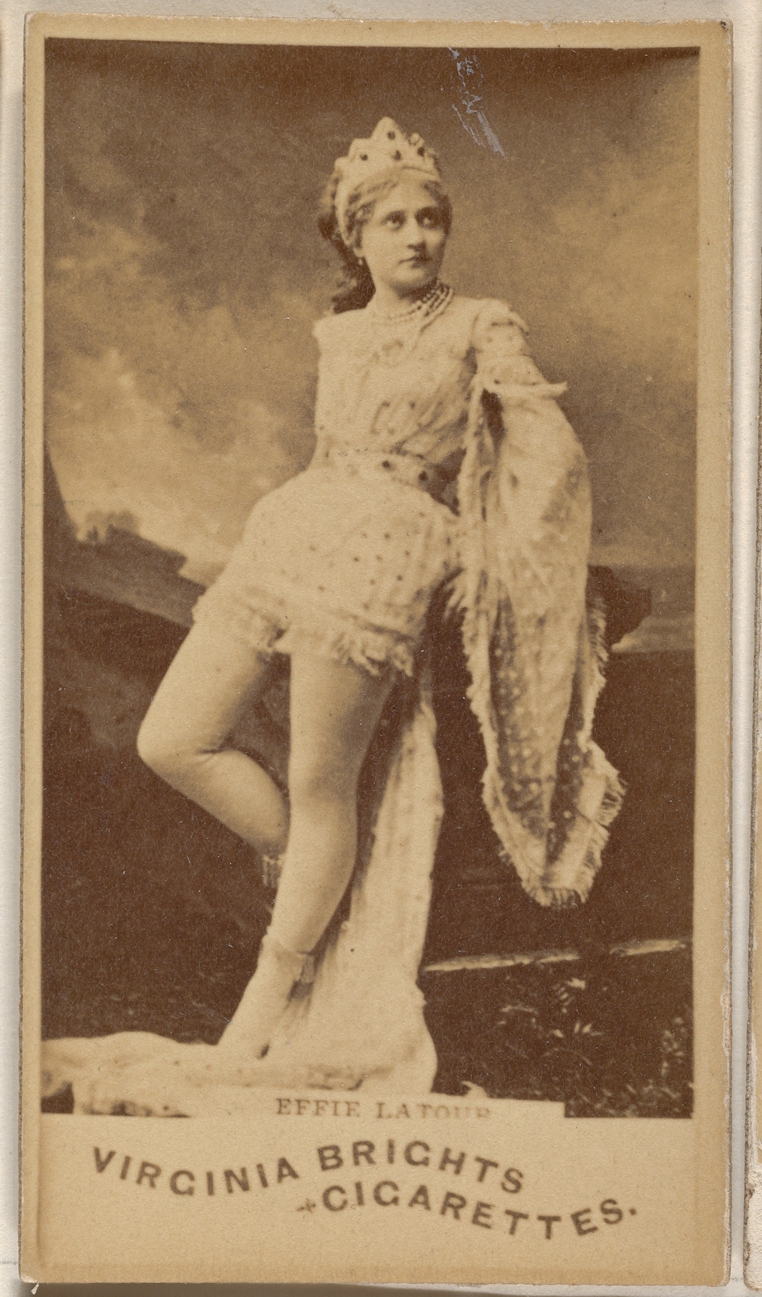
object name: photograph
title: Effie Latour, from the Actors and Actresses series (N45, Type 1) for Virginia Brights Cigarettes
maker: allen & ginter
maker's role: publisher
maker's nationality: american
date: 1888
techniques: albumen silver print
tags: portraits,women,actresses